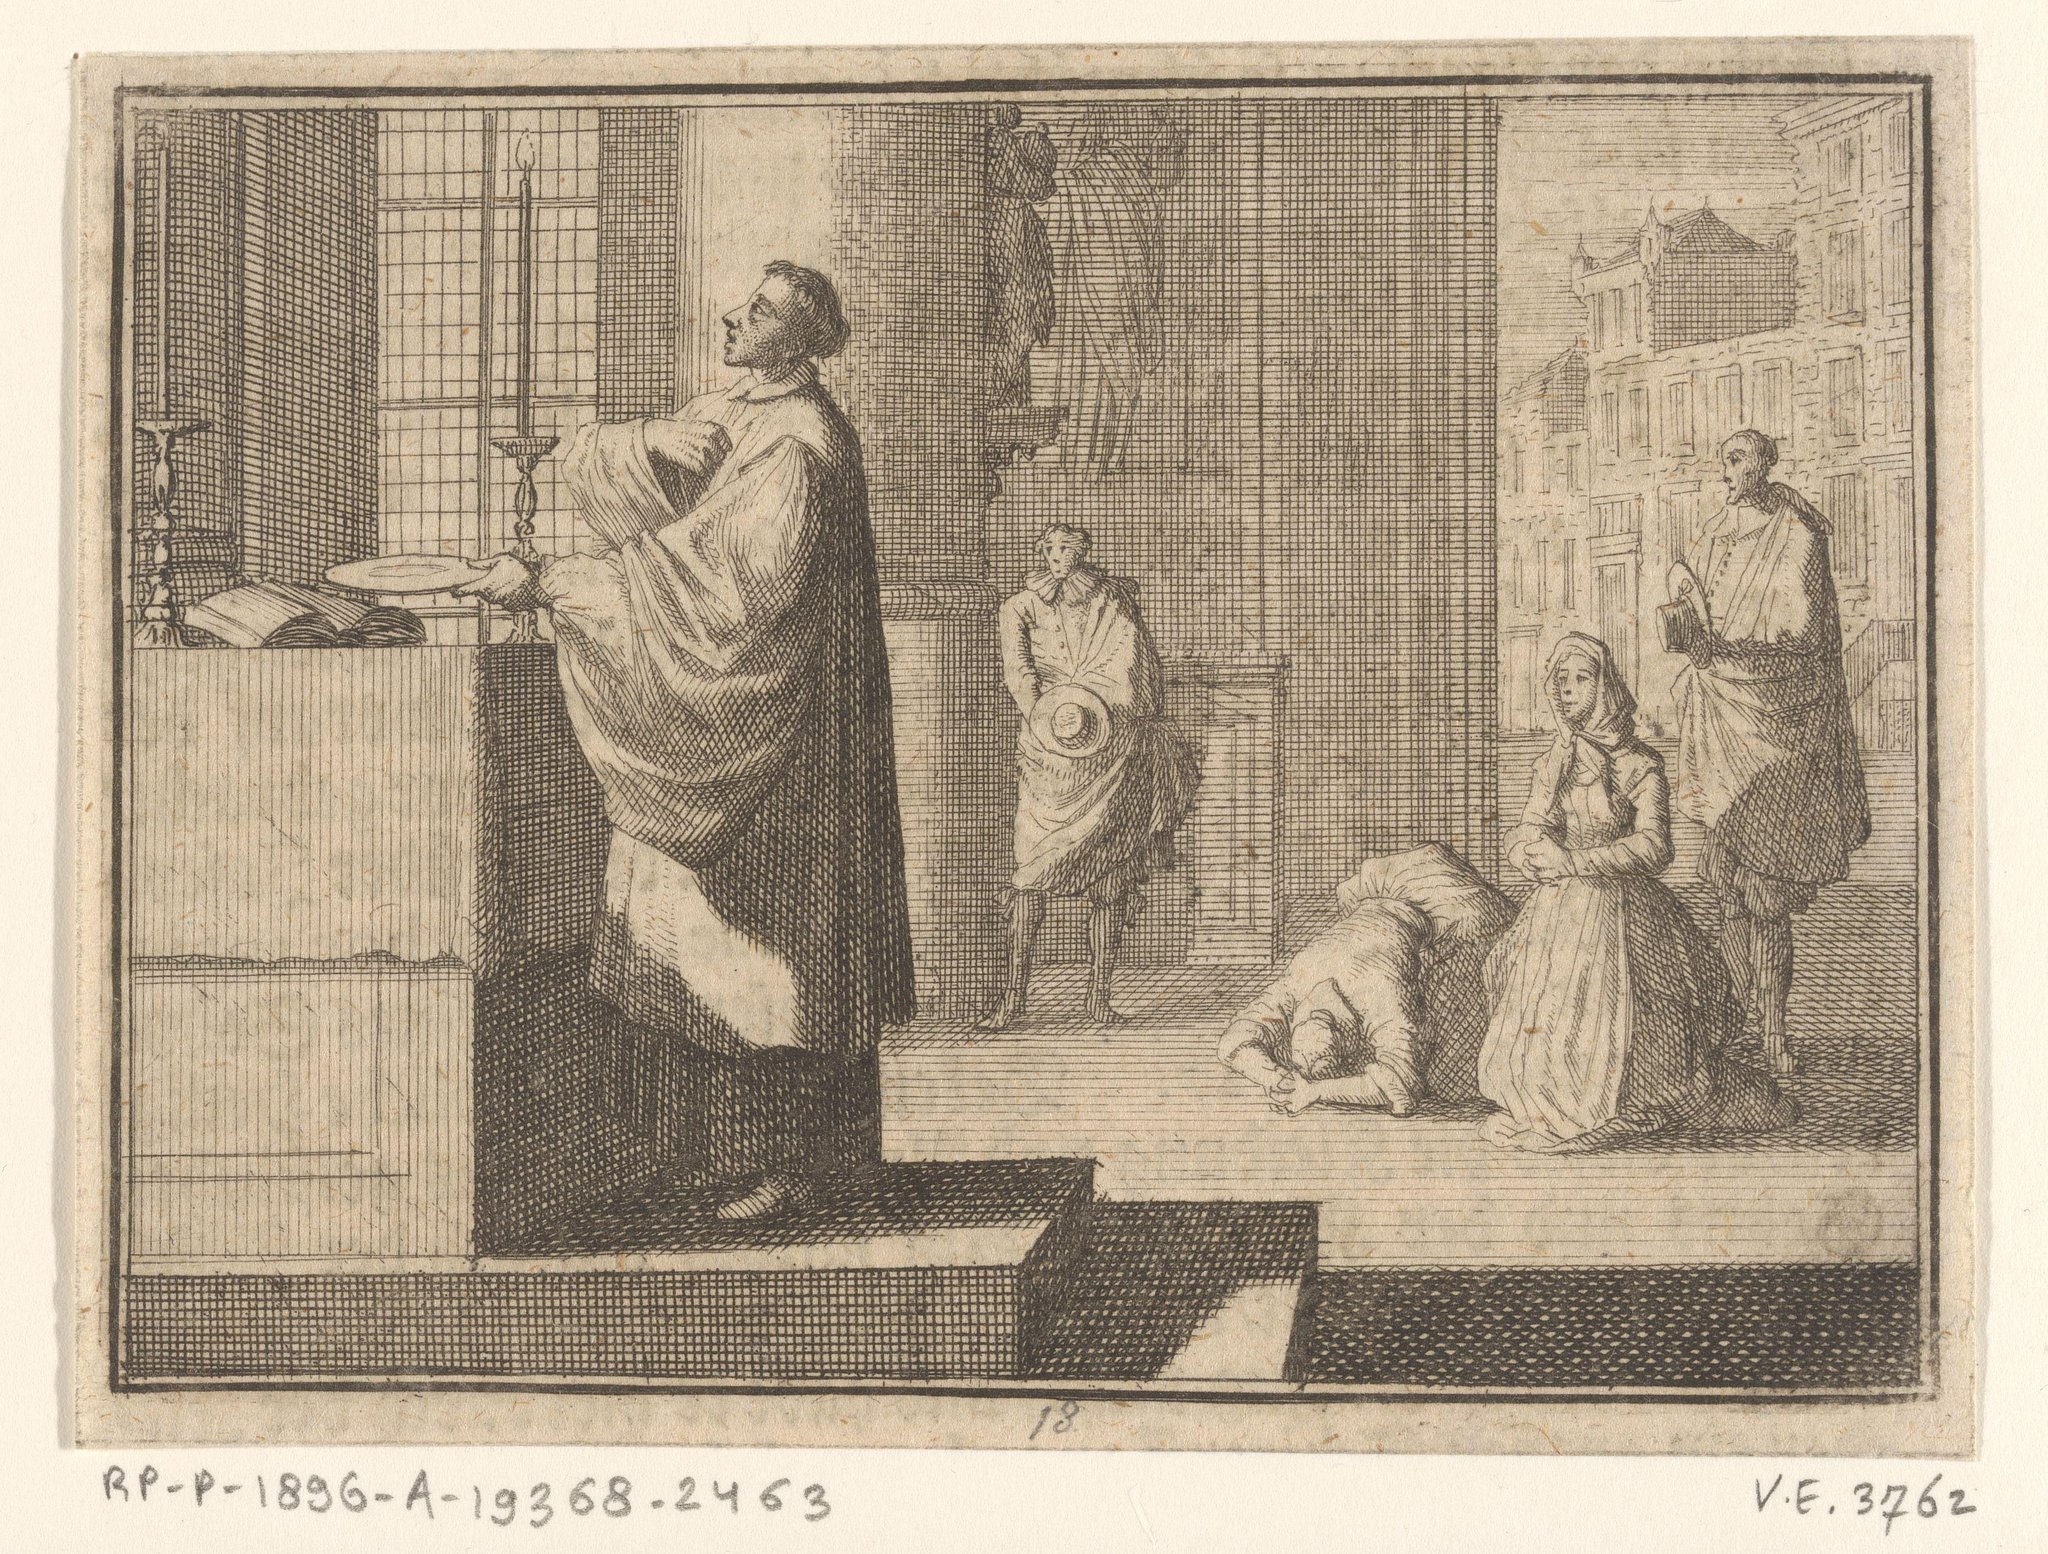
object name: book illustration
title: Caspar Igel von Sparheim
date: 1710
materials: paper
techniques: etching, letterpress printing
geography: nuremberg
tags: priests ~ hierarchy of priests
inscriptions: collector's mark: Lugt 2228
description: Illustratie uit: Abraham a Sancta Clara. Heilsames Gemisch Gemasch, das ist: Allerley seltsame und verwunderliche Geschichten (...). Neurenberg: Christoph Weigel, 1710, p. 164.